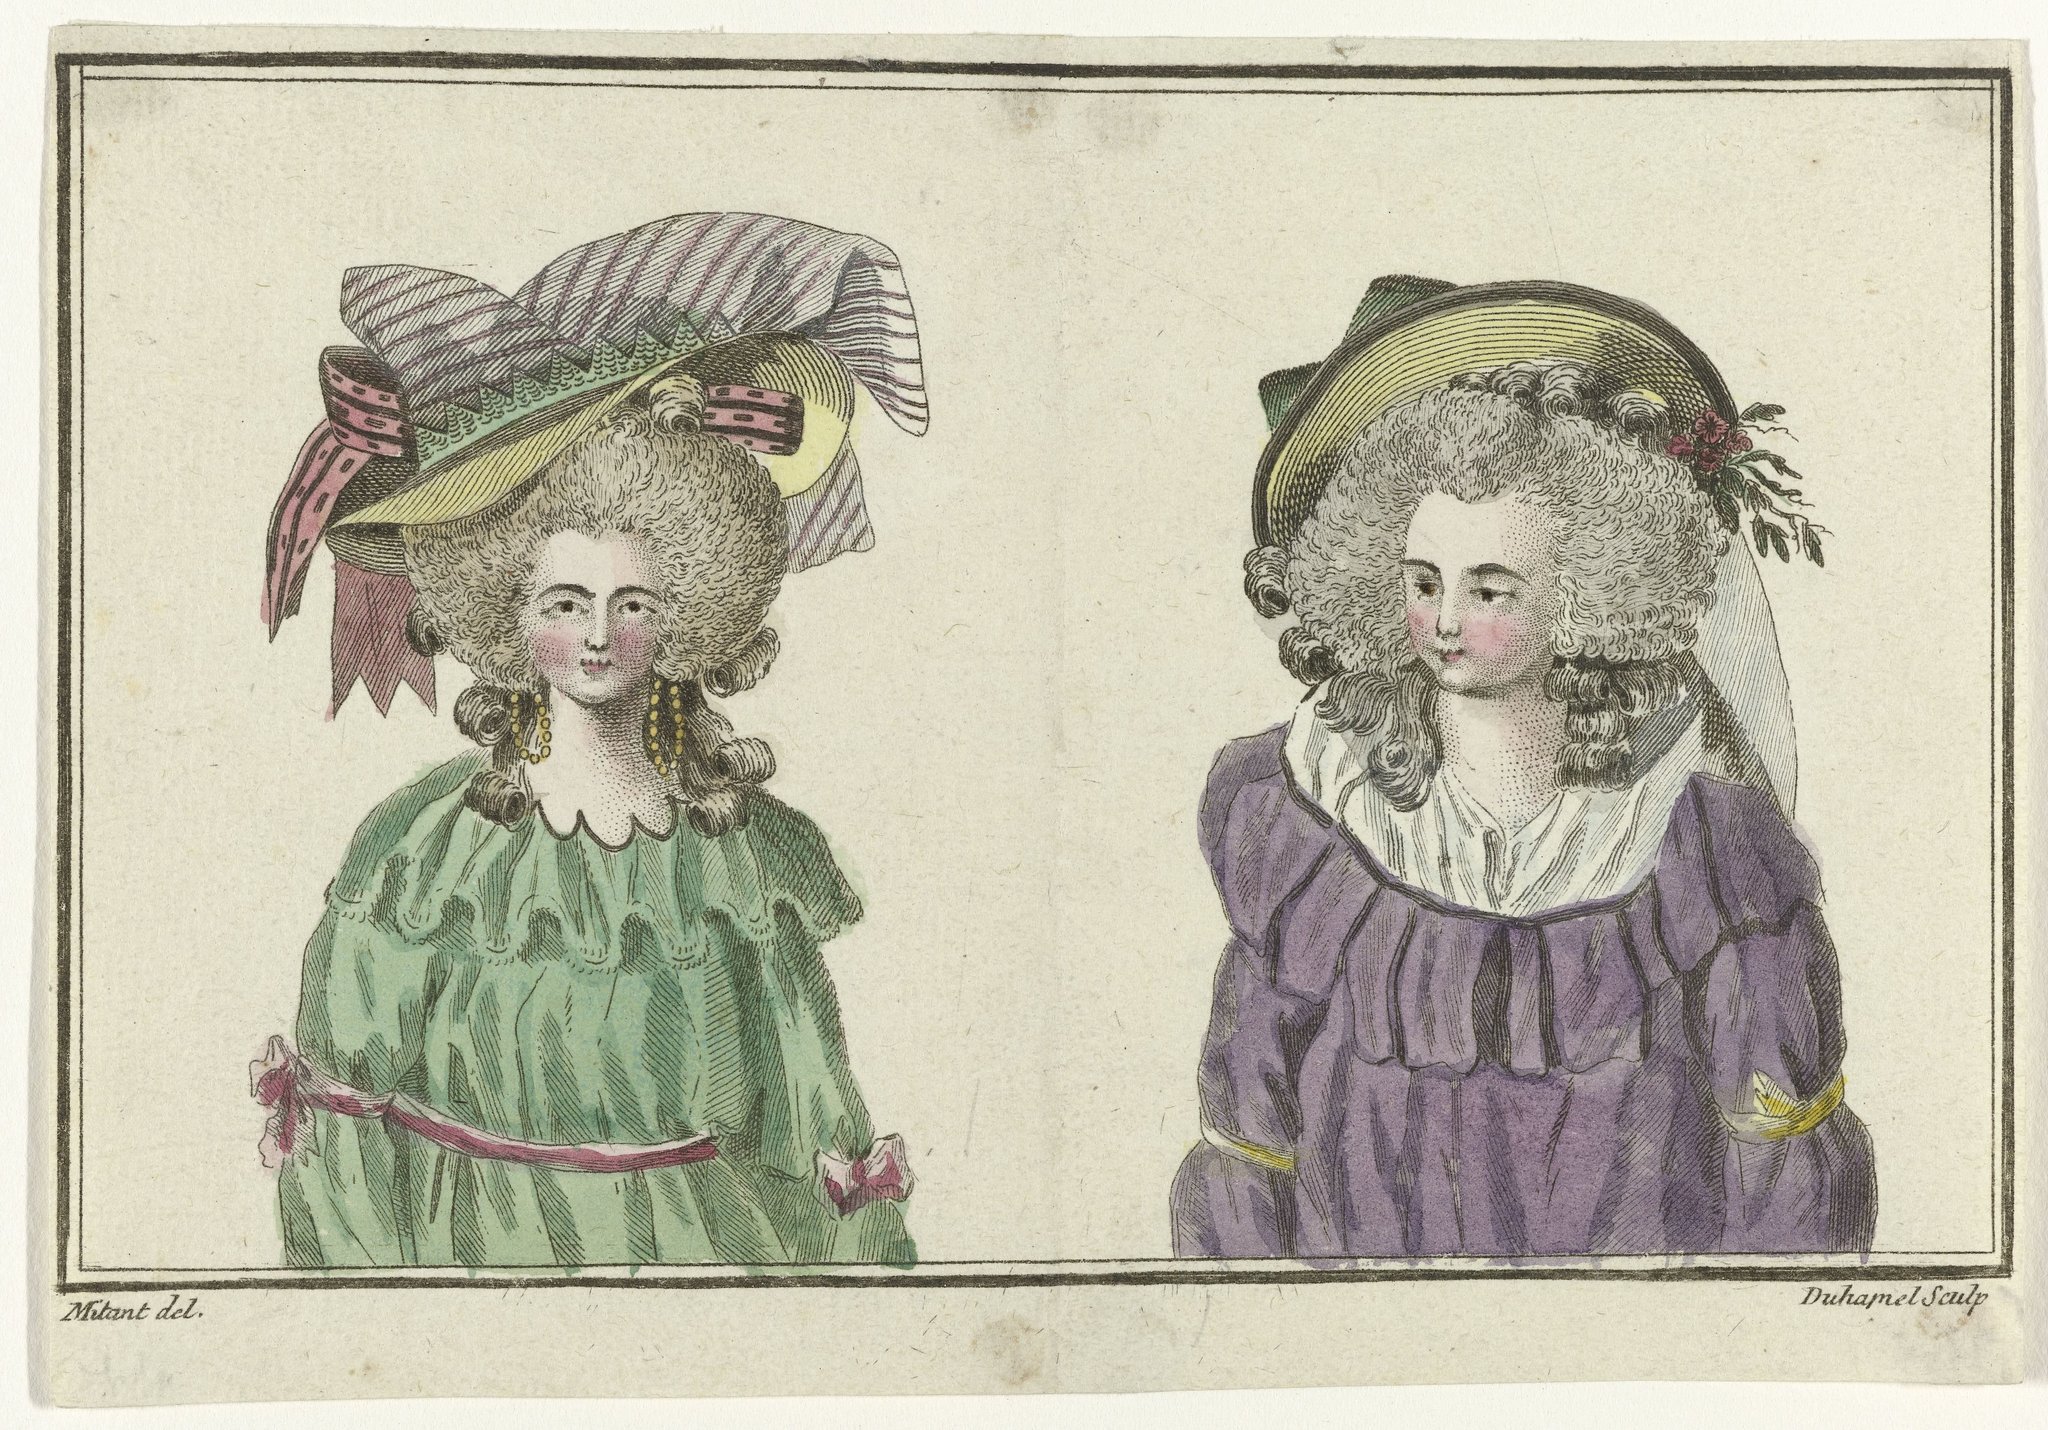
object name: fashion print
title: Magasin des Modes Nouvelles Françaises et Anglaises, 20 février 1787, Pl. 3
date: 1787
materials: paper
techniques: engraving, hand coloring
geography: paris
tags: clothing for the upper part of the body (+ women's clothes), ear-rings (+ women's clothes), artificial plants and flowers, head-gear (straw hat) (+ women's clothes), fashion plates, piece of clothing covering the breast or décolleté (fichu) (+ women's clothes)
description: Twee vrouwenbustes. Links een strohoed versierd met linten; rechts een strohoed versierd met kunstbloemen. De prent maakt deel uit van het 10e Cahier, 2e année, uit de serie Magasin des Modes Nouvelles Françaises et Anglaises. De serie bestaat uit 172 modeprenten, uitgegeven door Buisson, Parijs, 20 november 1786 - 21 décembre 1789. Deze Engelse vrouwen zijn overgenomen uit The Fashionable Magazine Londen 1786-1787